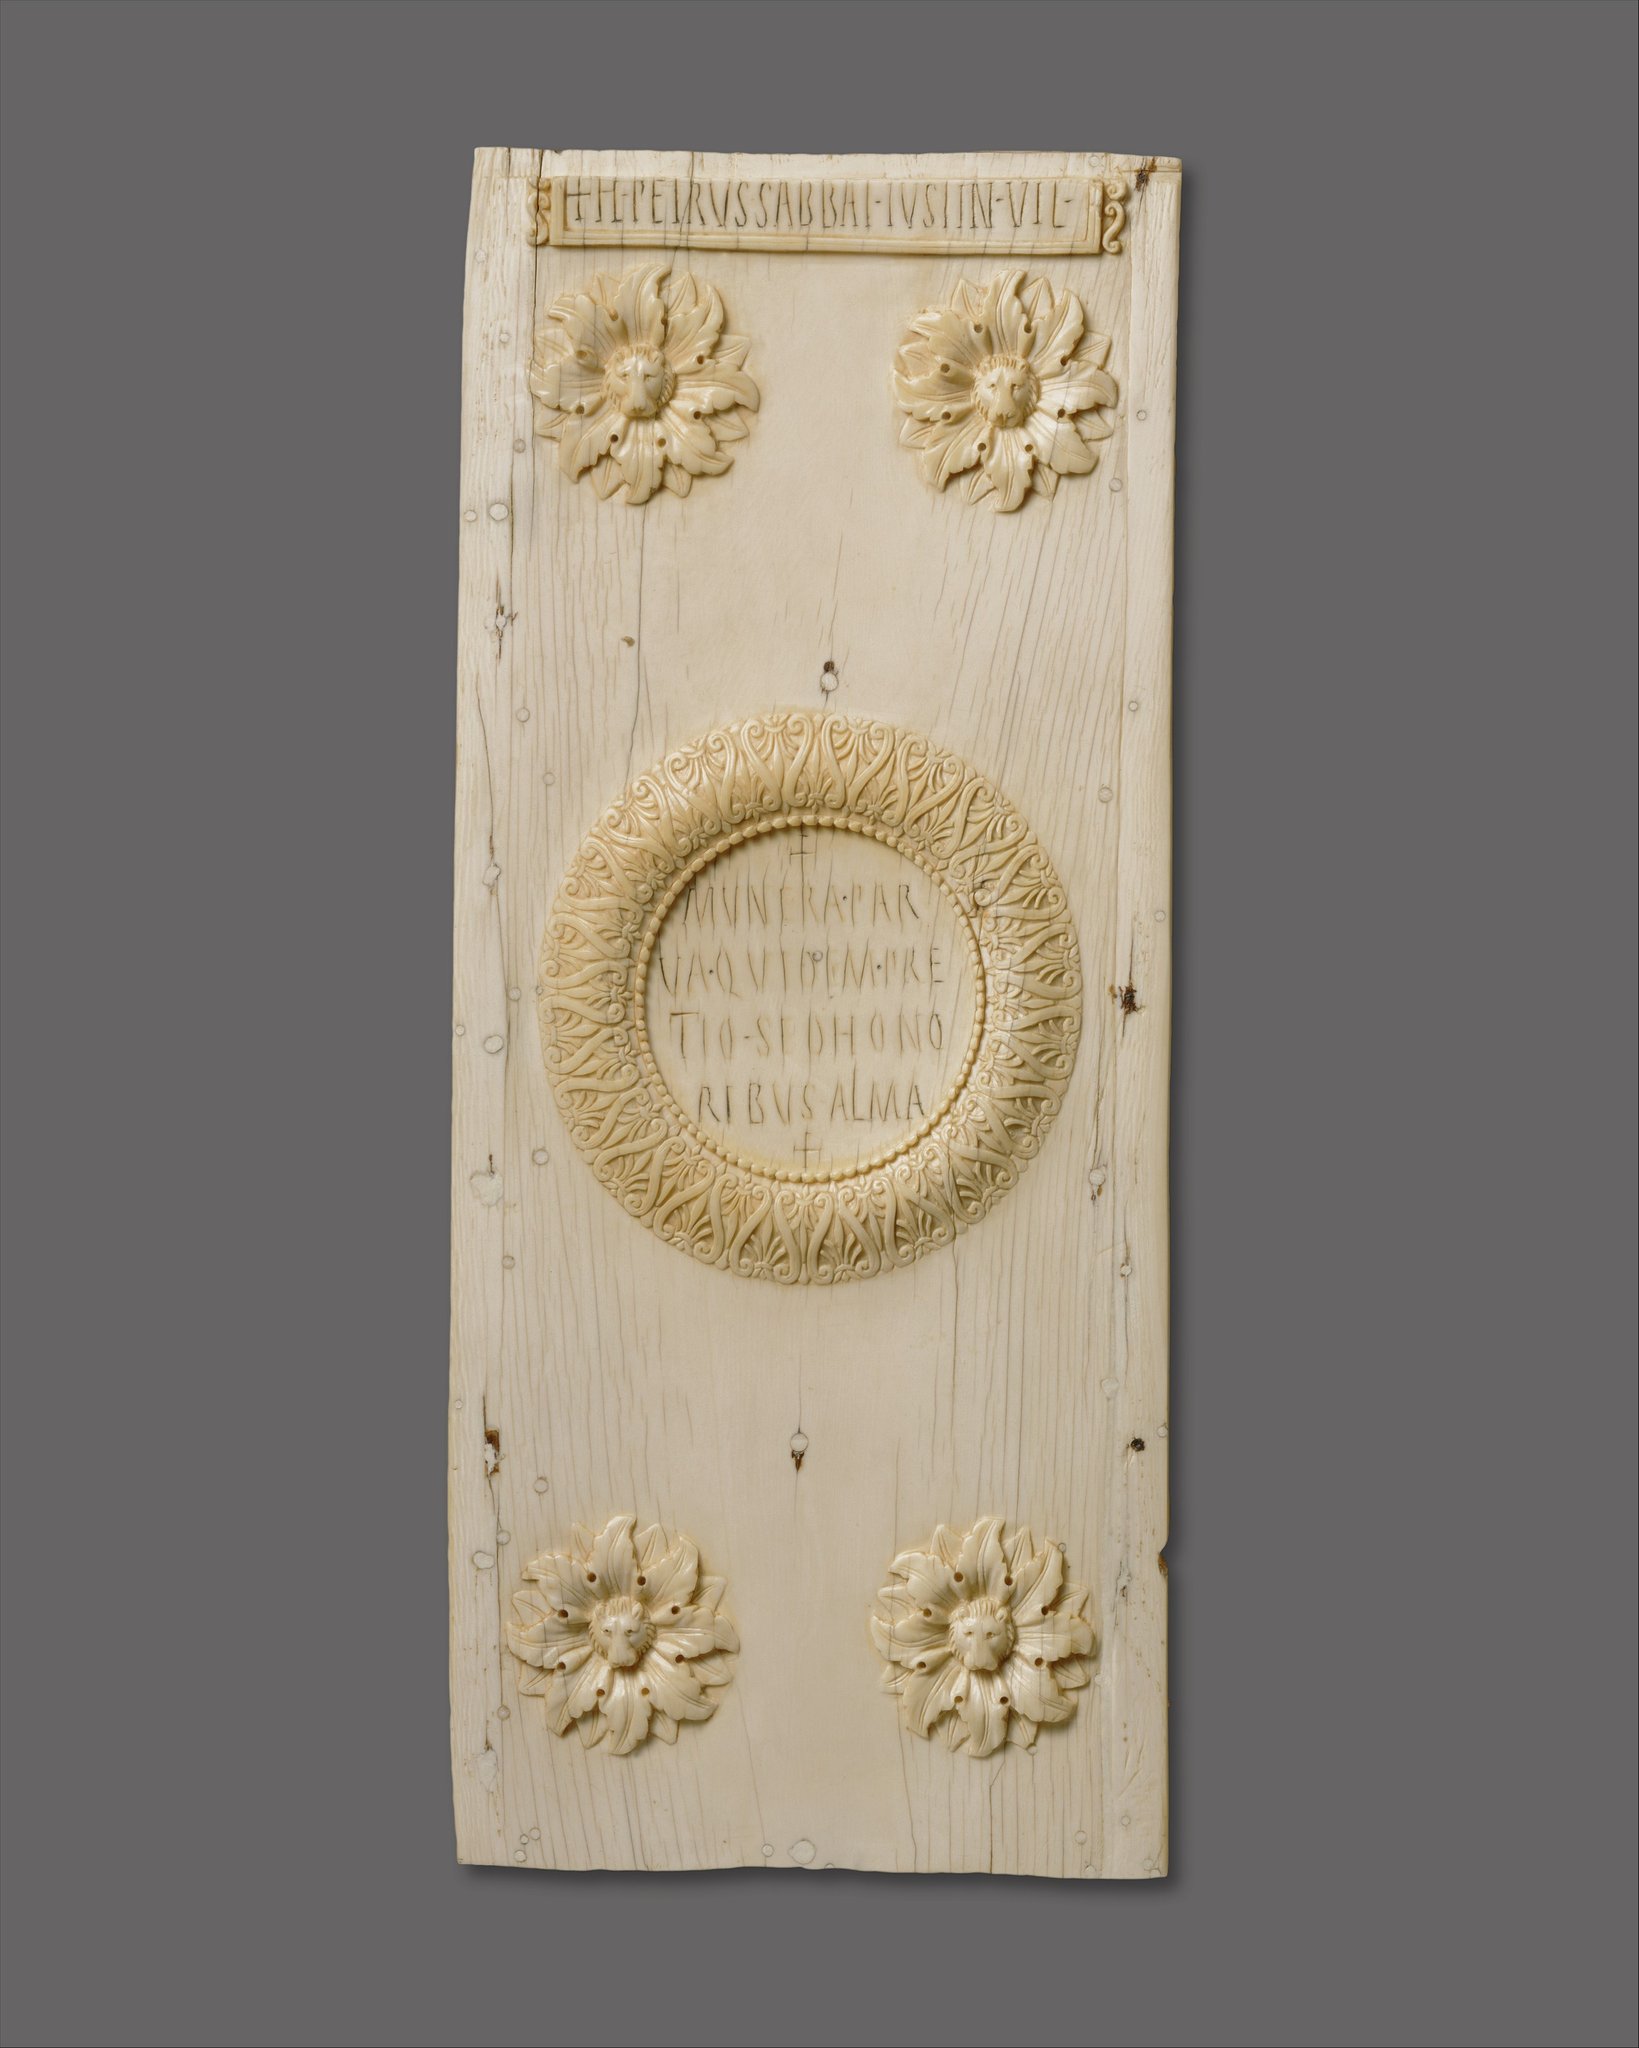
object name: diptych wing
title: Panel of a Diptych Announcing the Consulship of Justinian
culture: byzantine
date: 521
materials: ivory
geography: constantinople